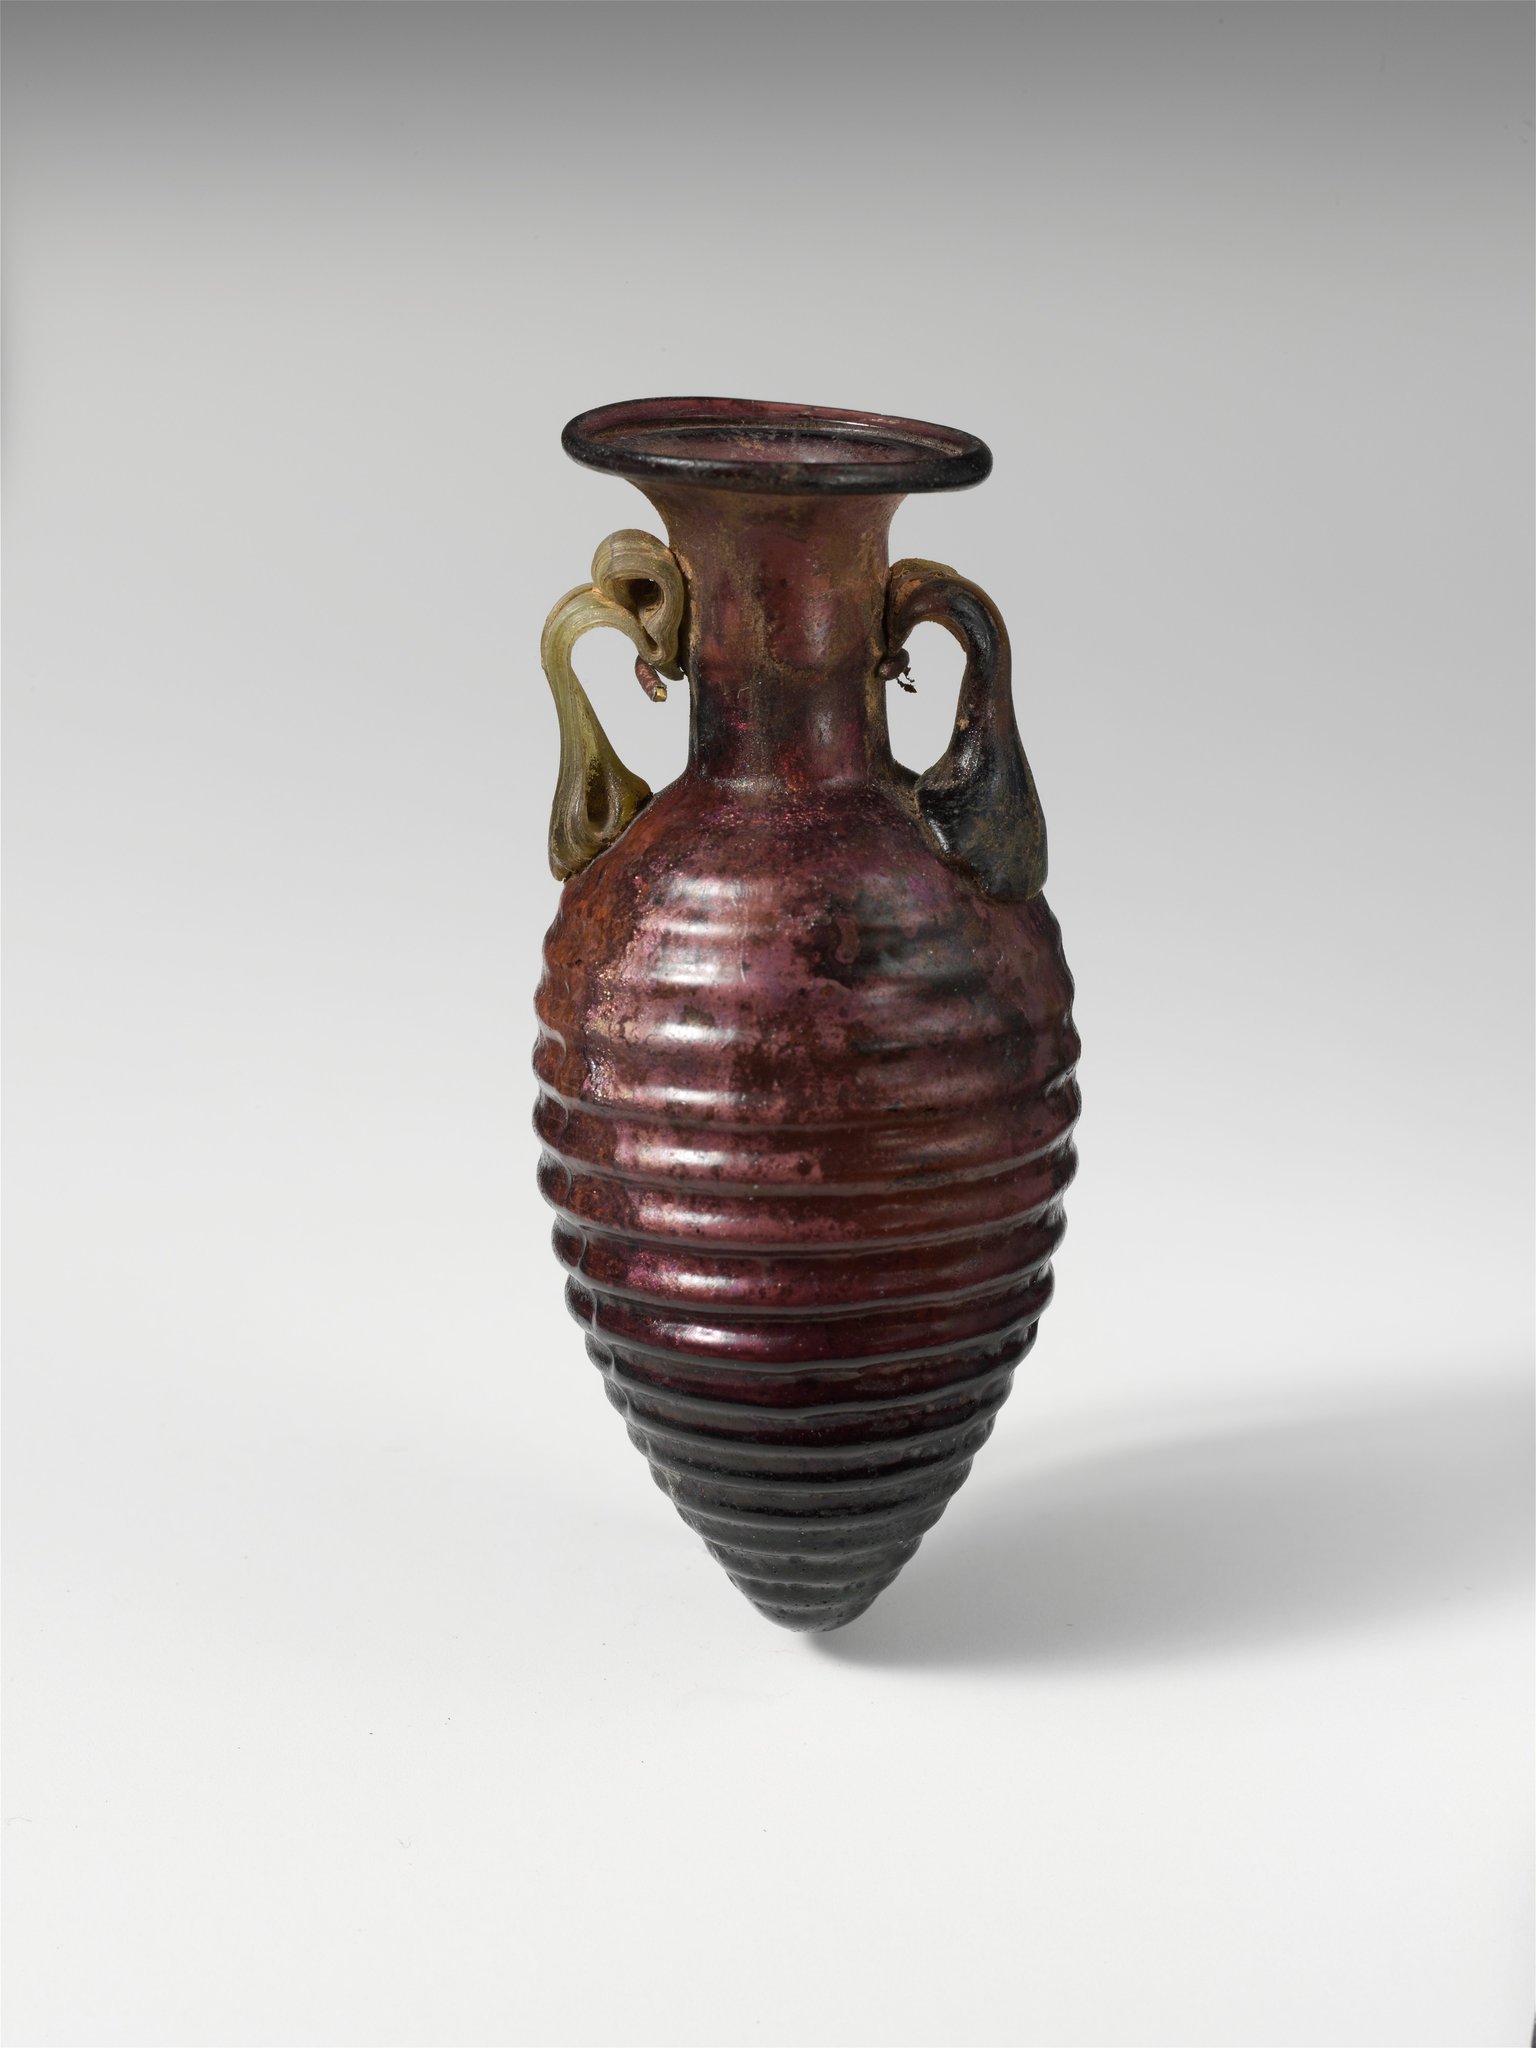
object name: miniature transport amphora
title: Glass amphoriskos with horizontal ribs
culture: roman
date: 51-100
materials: glass